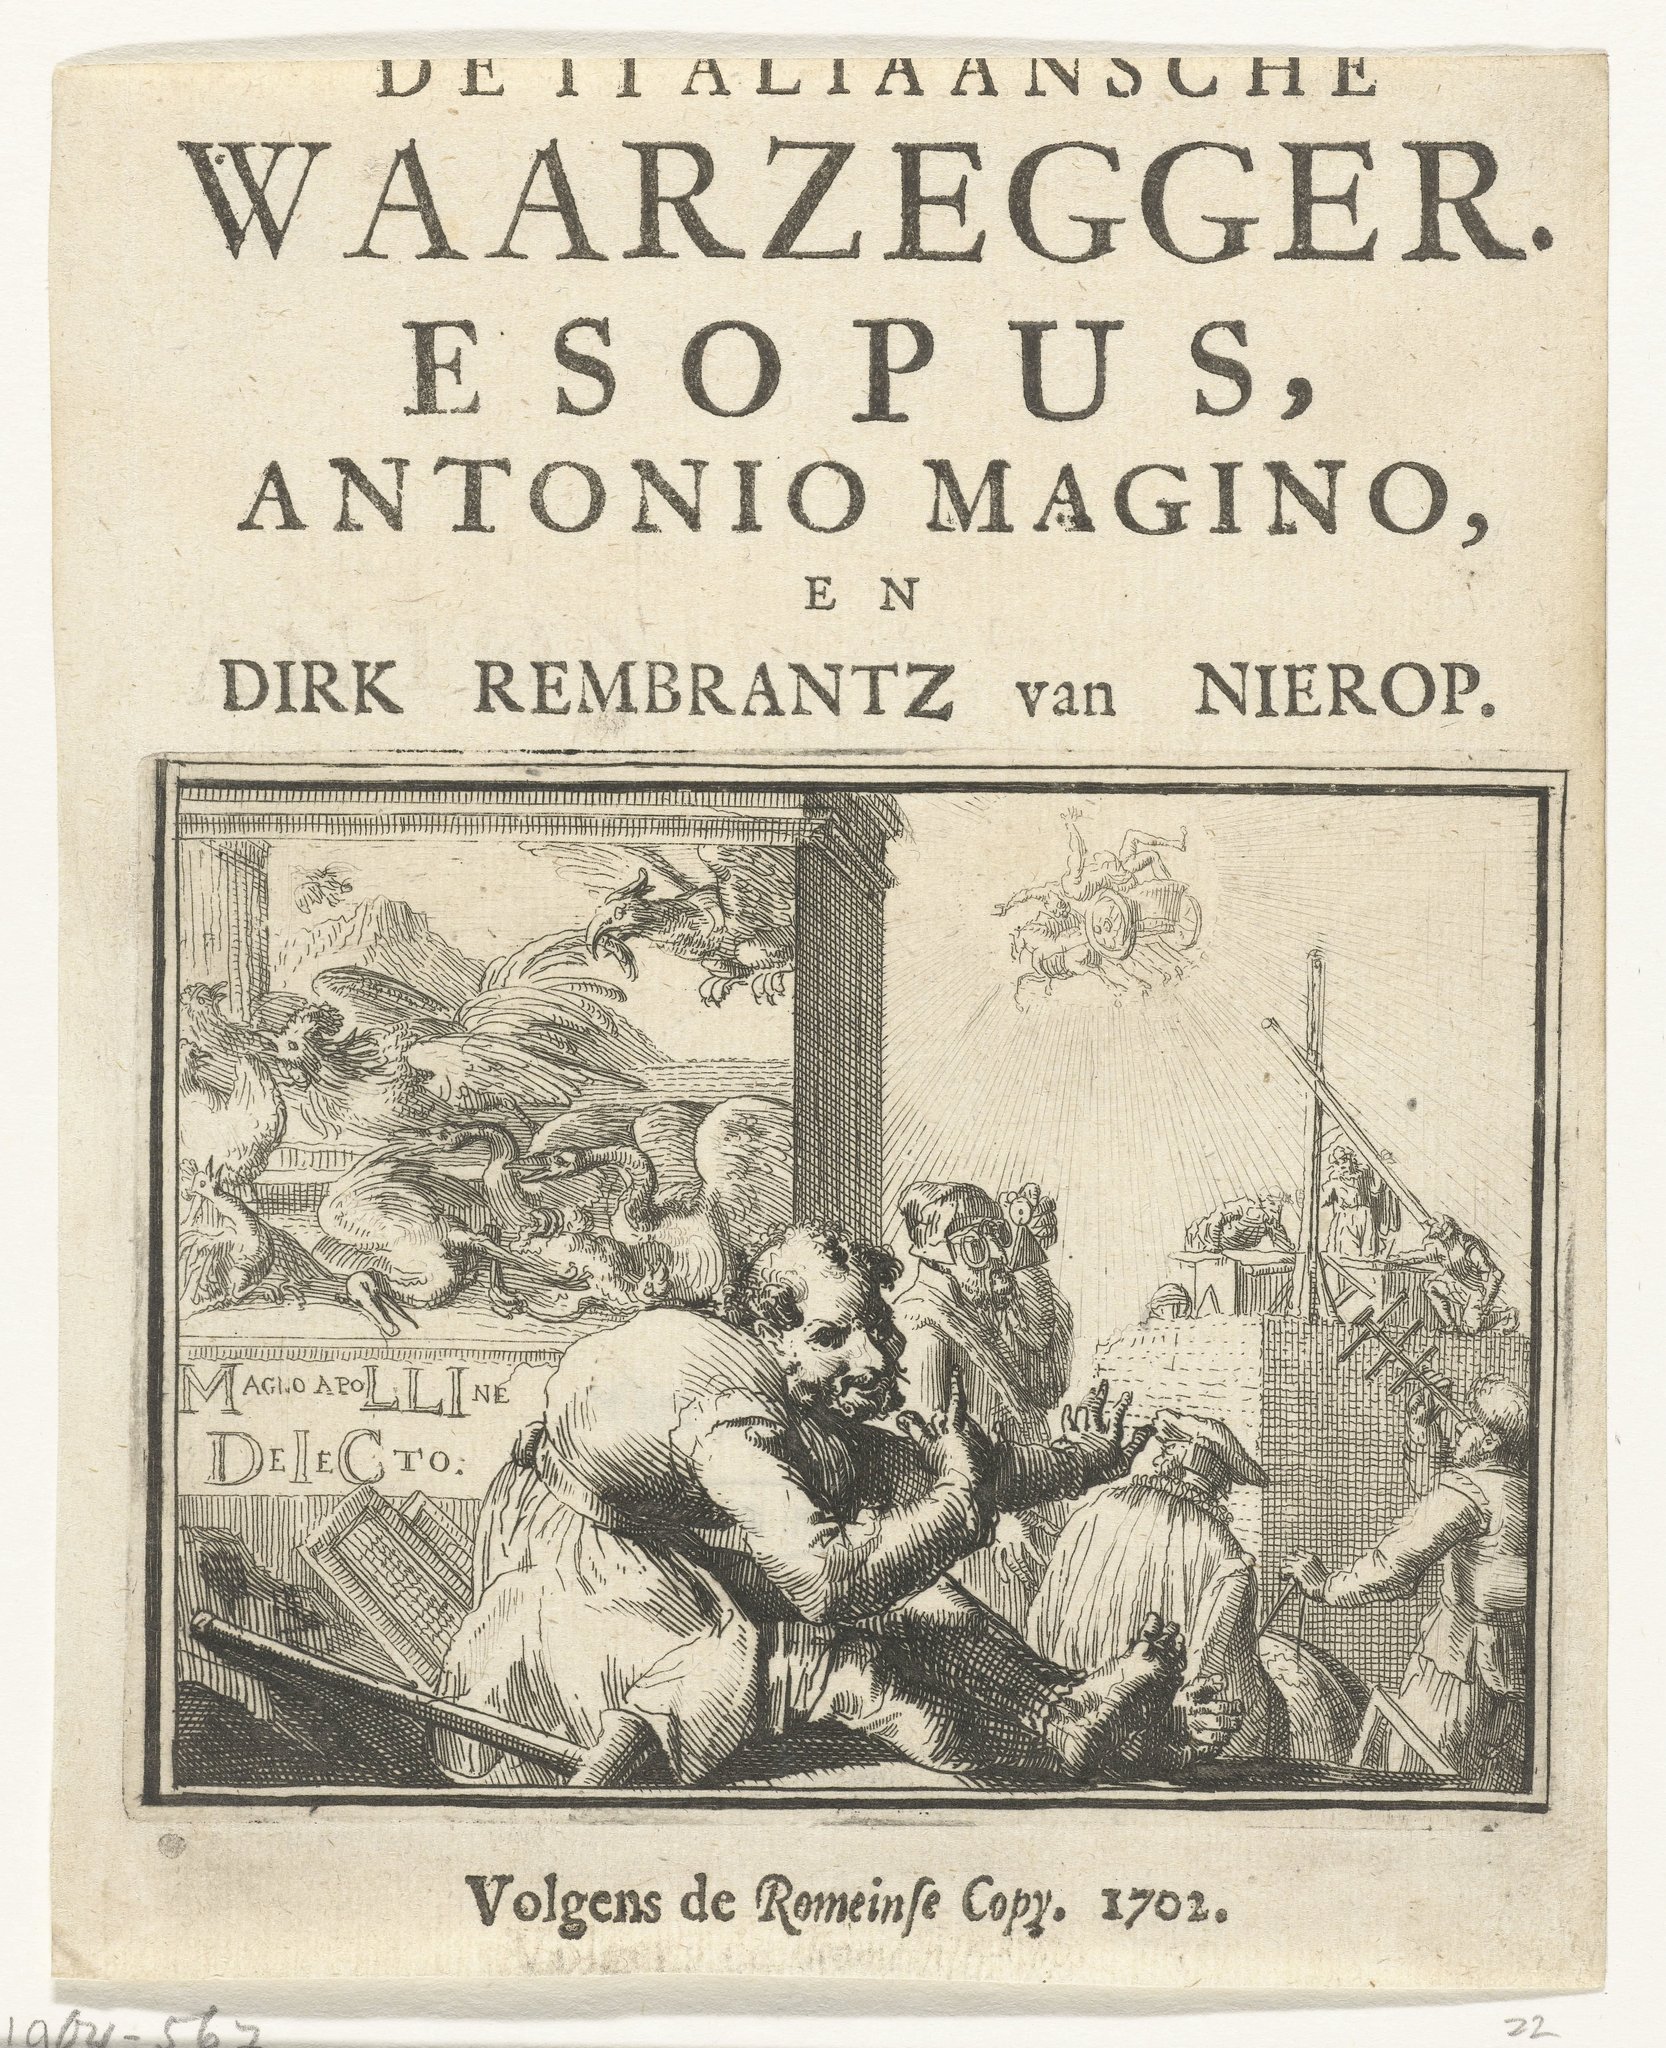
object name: print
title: De Italiaansche Waarzegger. Esopus, Antonio Magino, en Dirk Rembrantz van Nierop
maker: romeyn de hooghe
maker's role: draughtsman, goldsmith, painter, print maker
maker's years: 1645-1708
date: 1702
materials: paper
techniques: etching, letterpress printing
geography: northern netherlands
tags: lodewijk xiv (koning van frankrijk), telescope, fall of phaethon; he is struck by a thunderbolt of jupiter, astronomy (and cosmography)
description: Titelblad voor het pamflet: De Italiaansche Waarzegger. Esopus, Antonio Magino, en Dirk Rembrantz van Nierop, 1702. Wetenschappers kijken met telescopen naar de hemel waarin Phaëthon (Lodewijk XIV) uit de zonnewagen valt. Op de voorgrond een bedelaar met een bochel (Esopus). Op de achtergrond een tableau met vogels die de vechtende vorsten symboliseren.